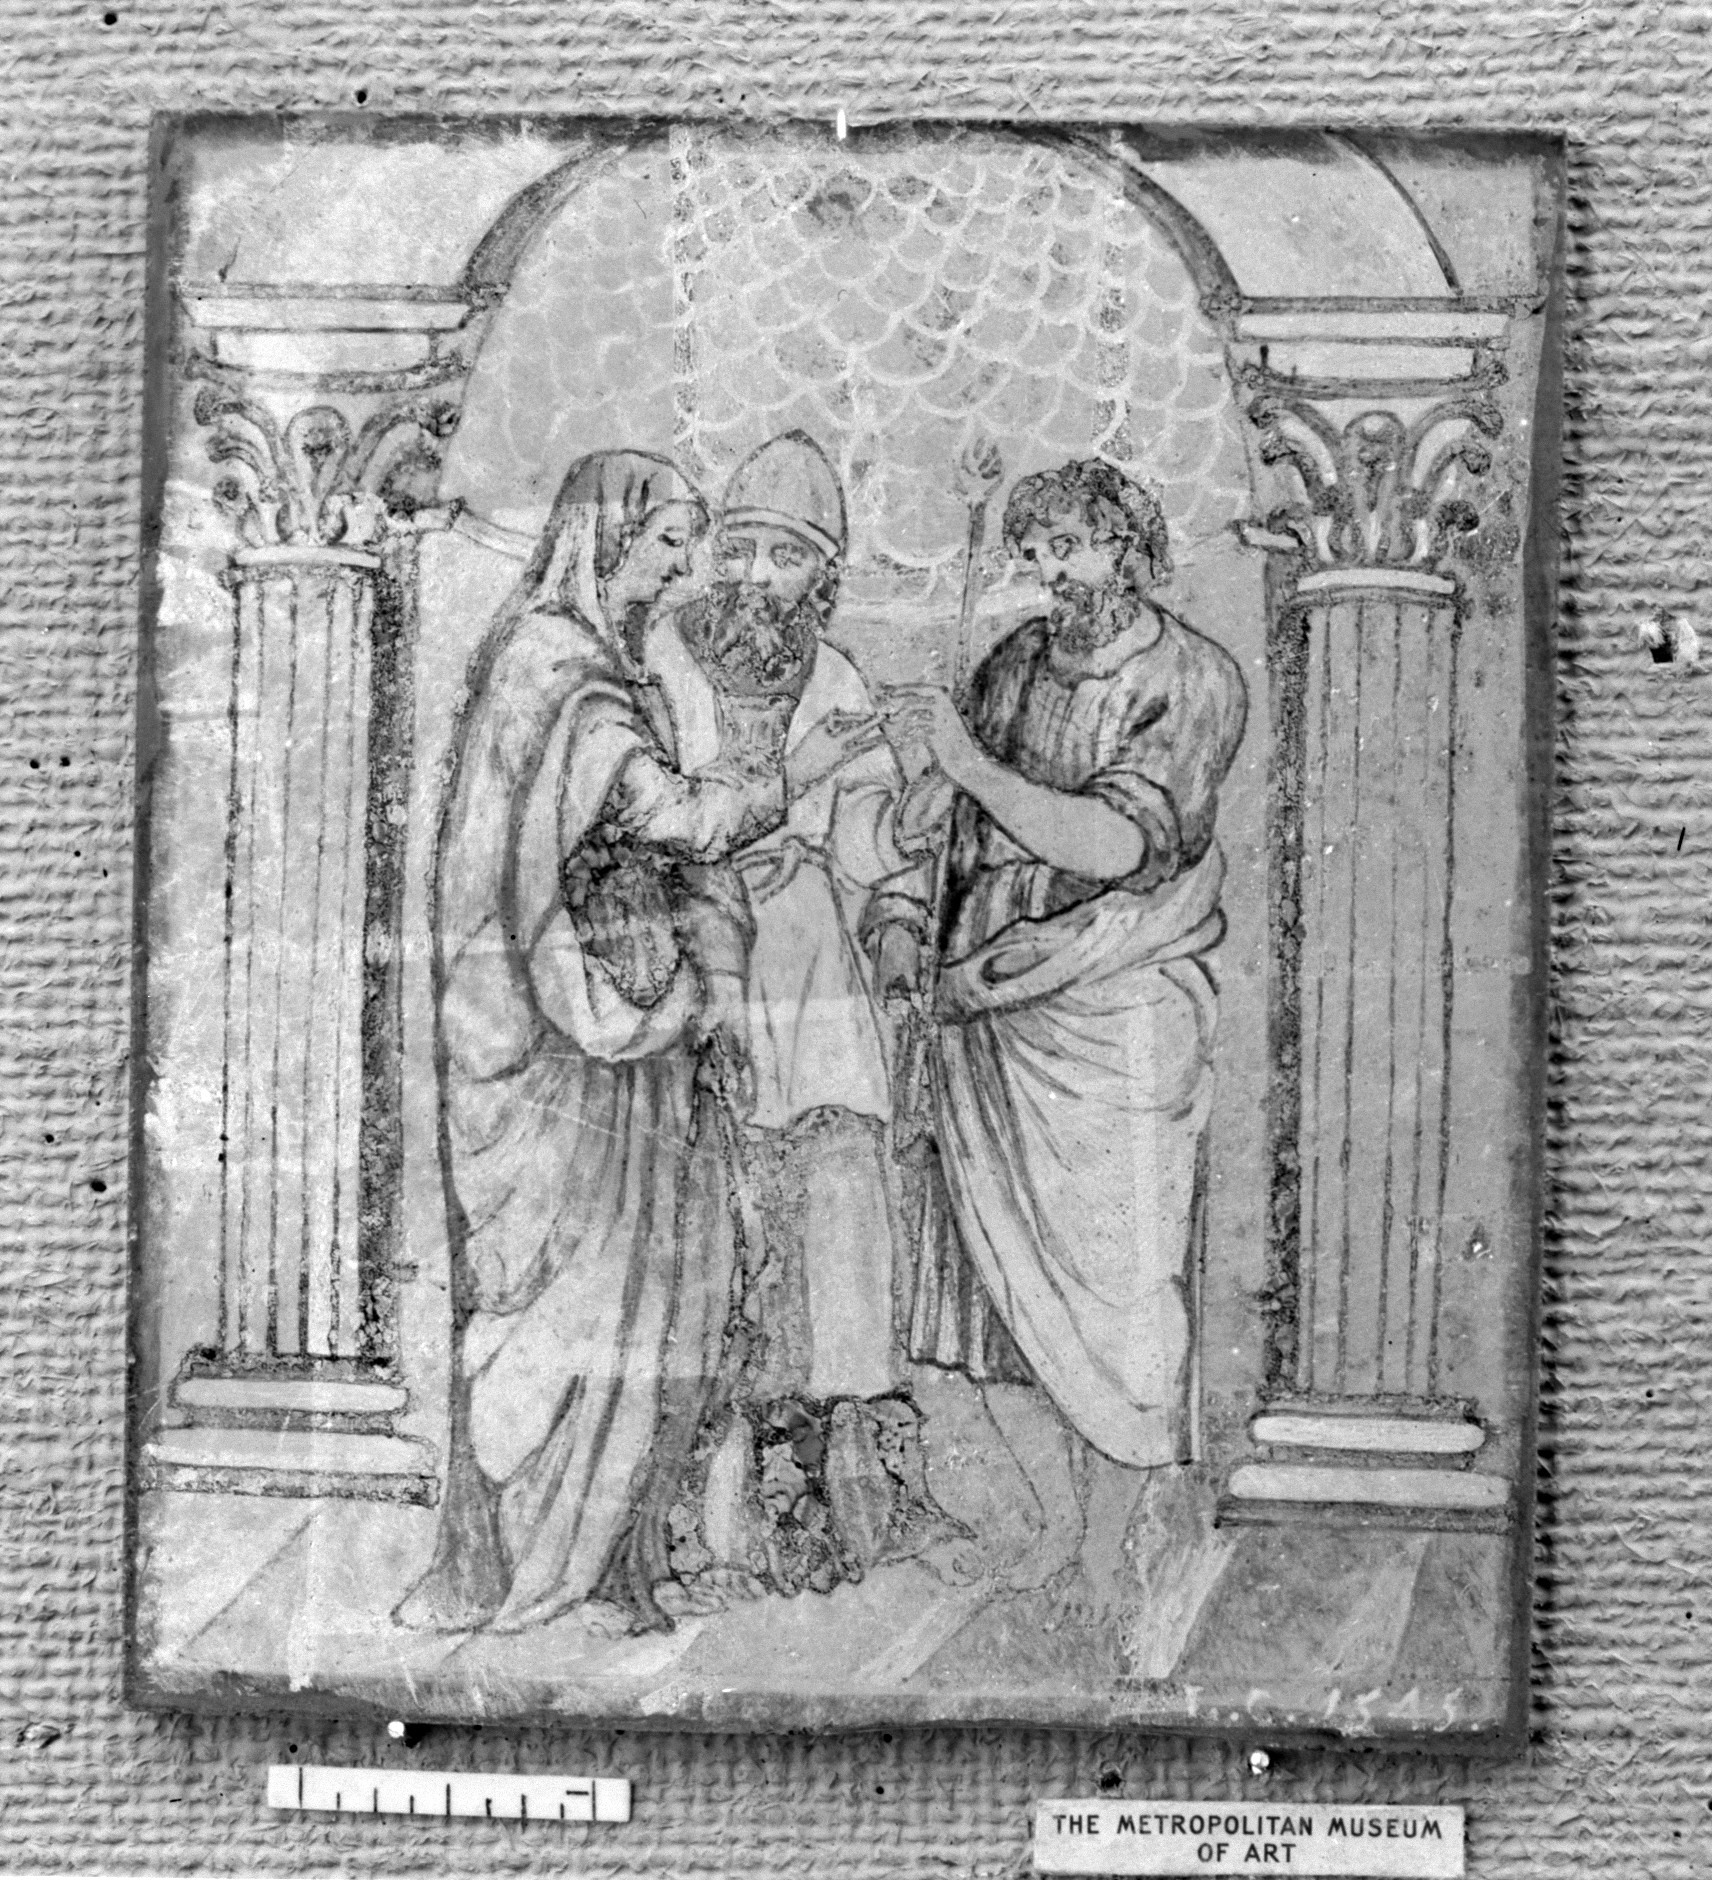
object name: panel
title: Marriage of the Virgin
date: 1601-1800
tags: men,virgin mary